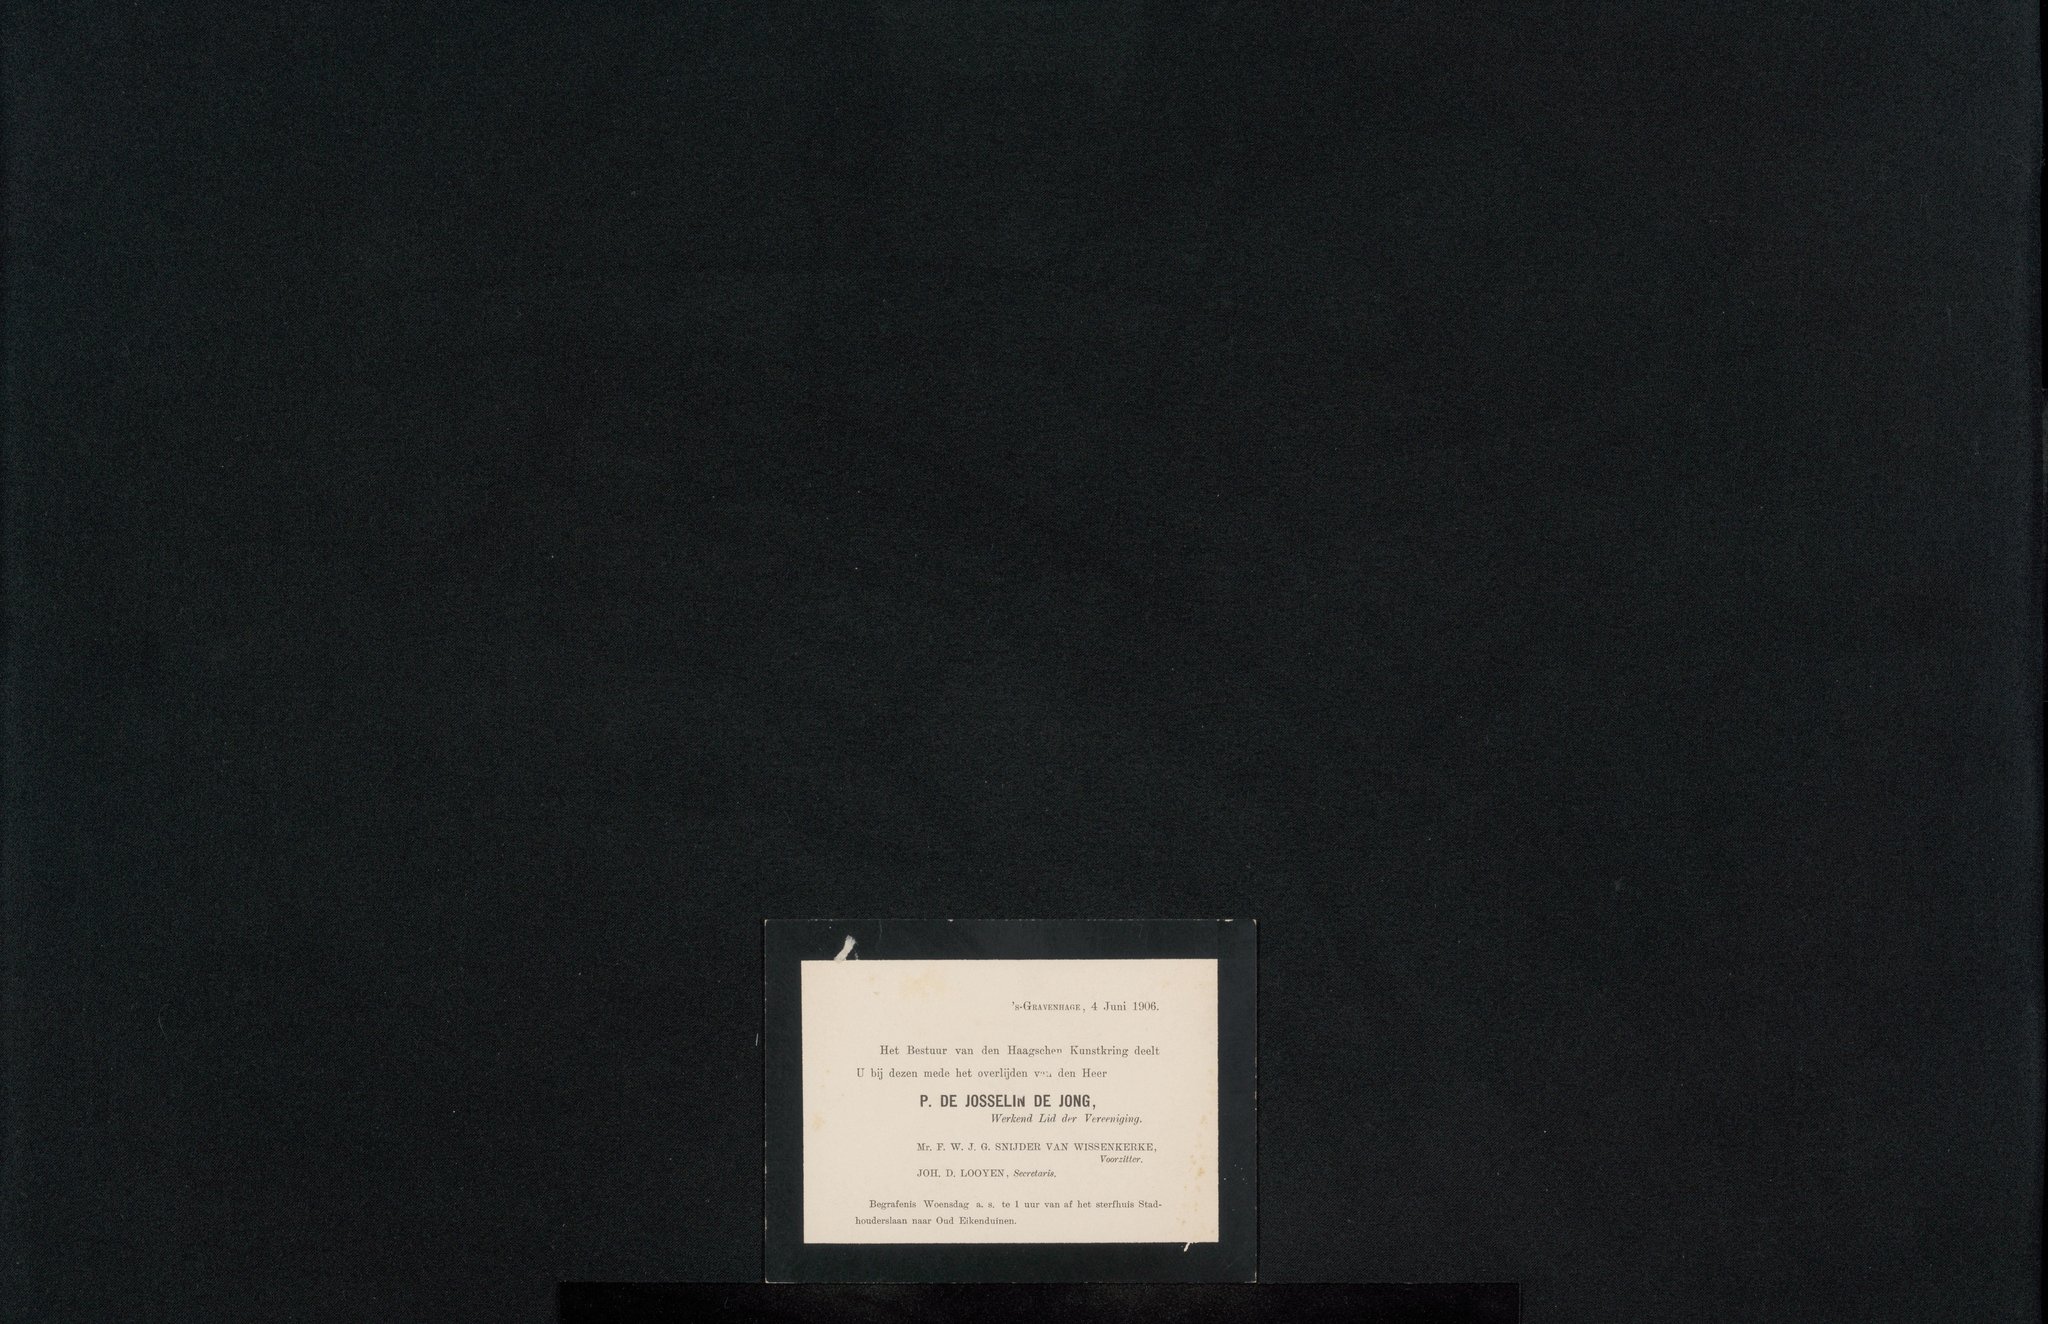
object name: overlijdensbericht, overlijdensadvertentie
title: Overlijdensbericht aan Philip Zilcken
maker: Anonymous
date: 1906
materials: cardboard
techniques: printing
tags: print maker, pieter de josselin de jong, middelburg, the hague, frans willem jan george snijder van wissenkerke, johan dionysius looyen, draughtsman, philip zilcken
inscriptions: collector's mark: ‘RPK’